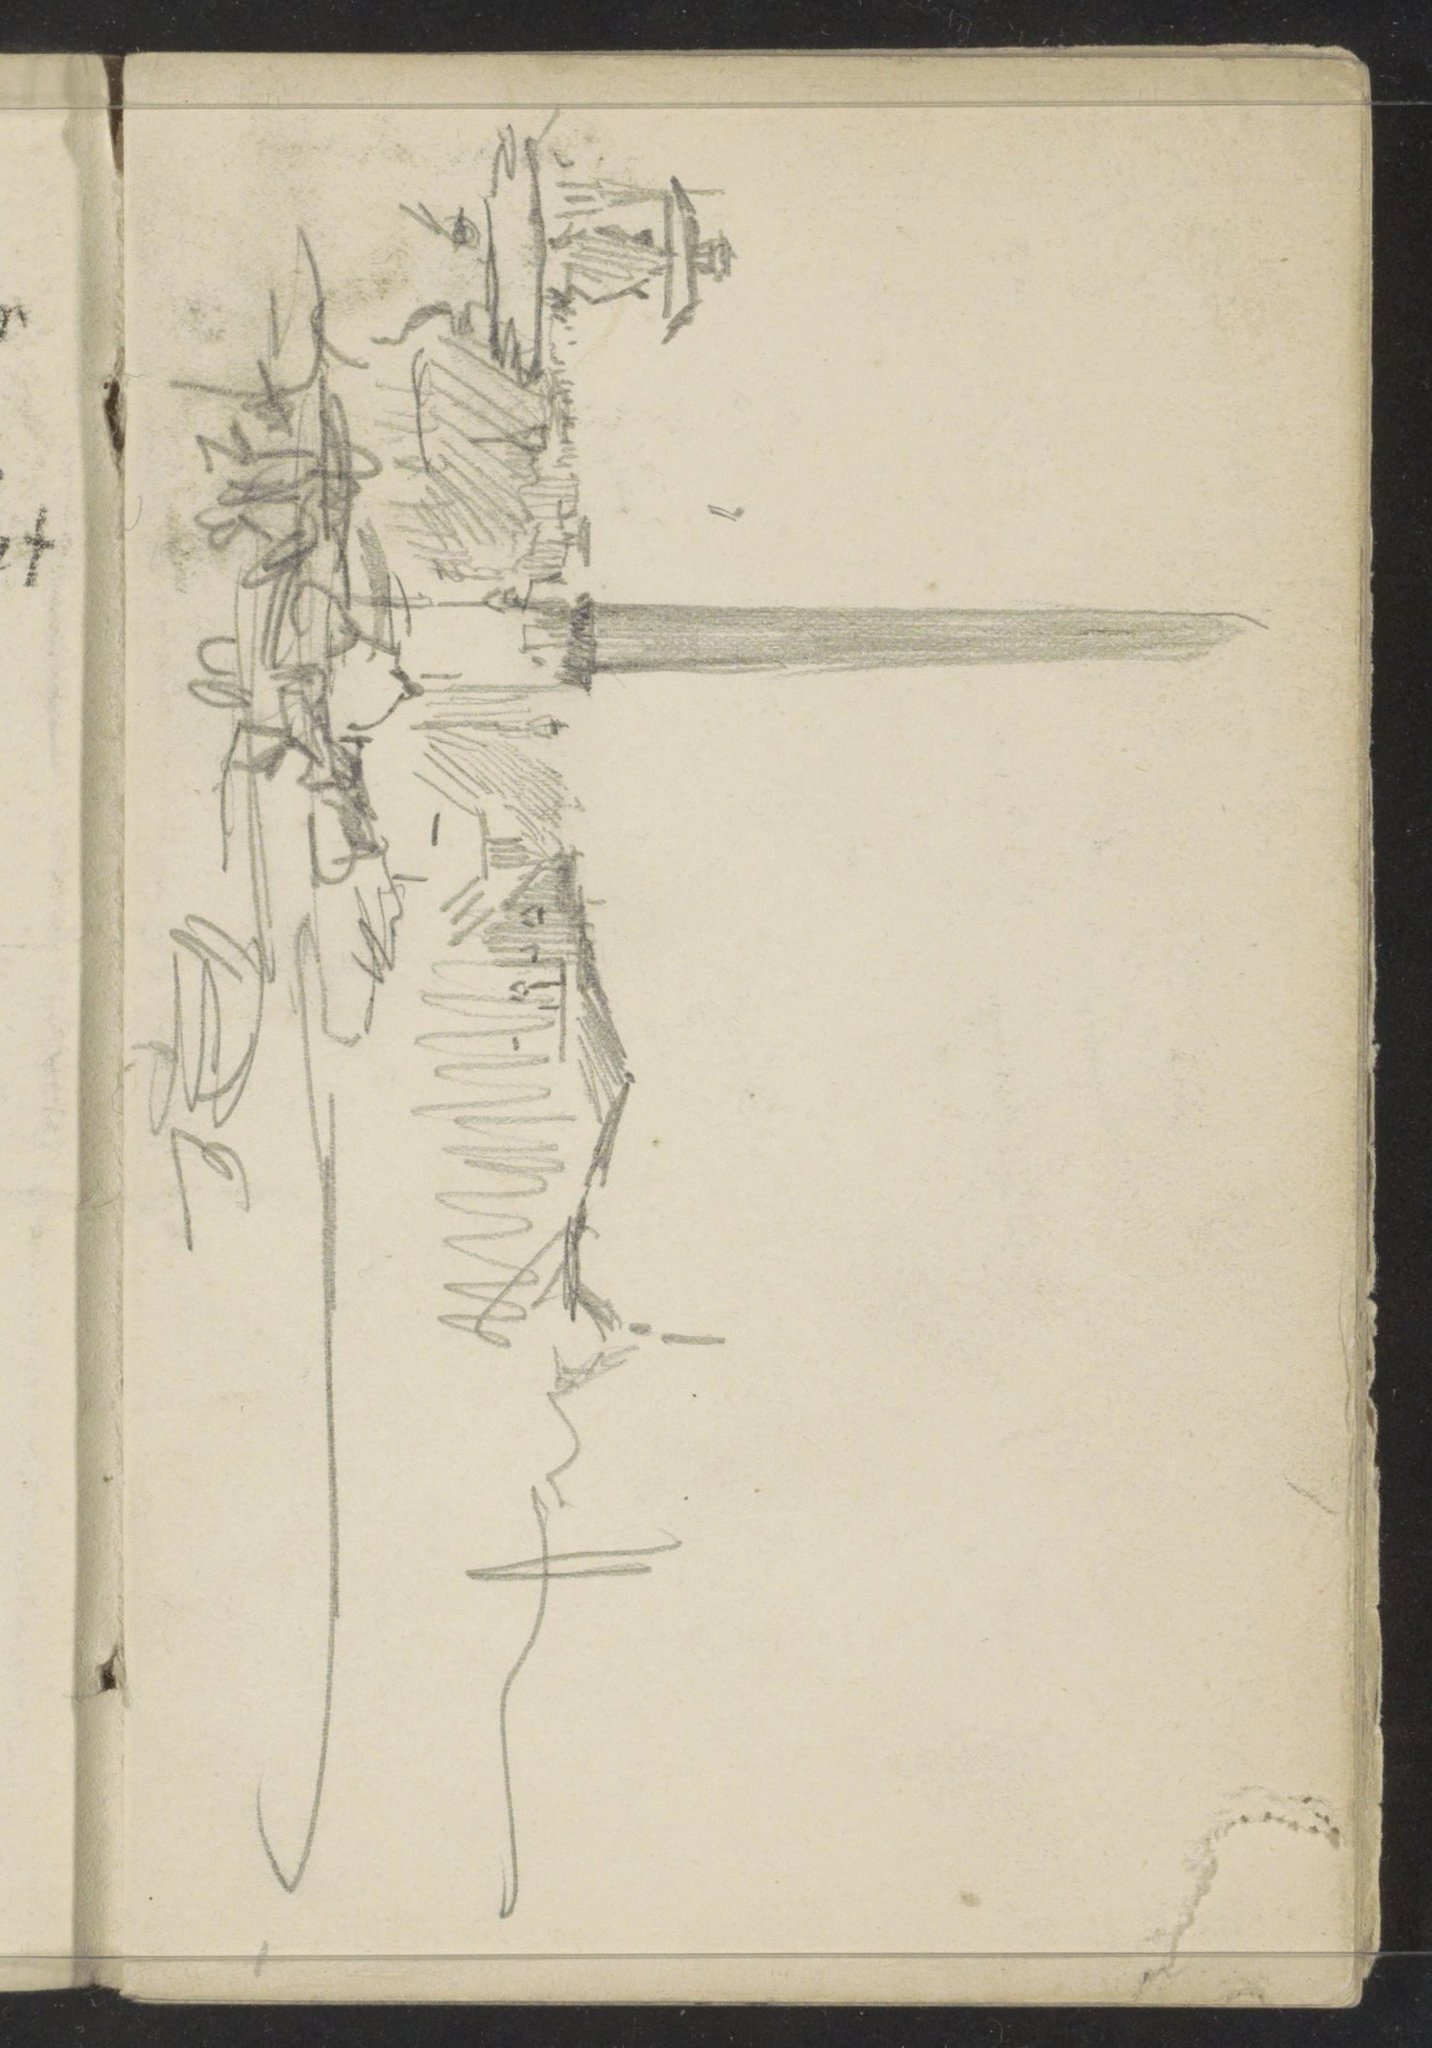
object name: sketchbook leaf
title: Gezicht op het Place de la Concorde te Parijs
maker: isaac israels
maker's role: draughtsman, painter, print maker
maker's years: 1865-1934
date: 1887-1934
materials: paper, pencil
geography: paris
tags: square, place, circus, etc.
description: Vooraan een fontein en de obelisk. Op de achtergrond het Palais Bourbon en de koepel van de Dôme des Invalides. Blad 1 recto uit schetsboek LIX met 21 bladen.